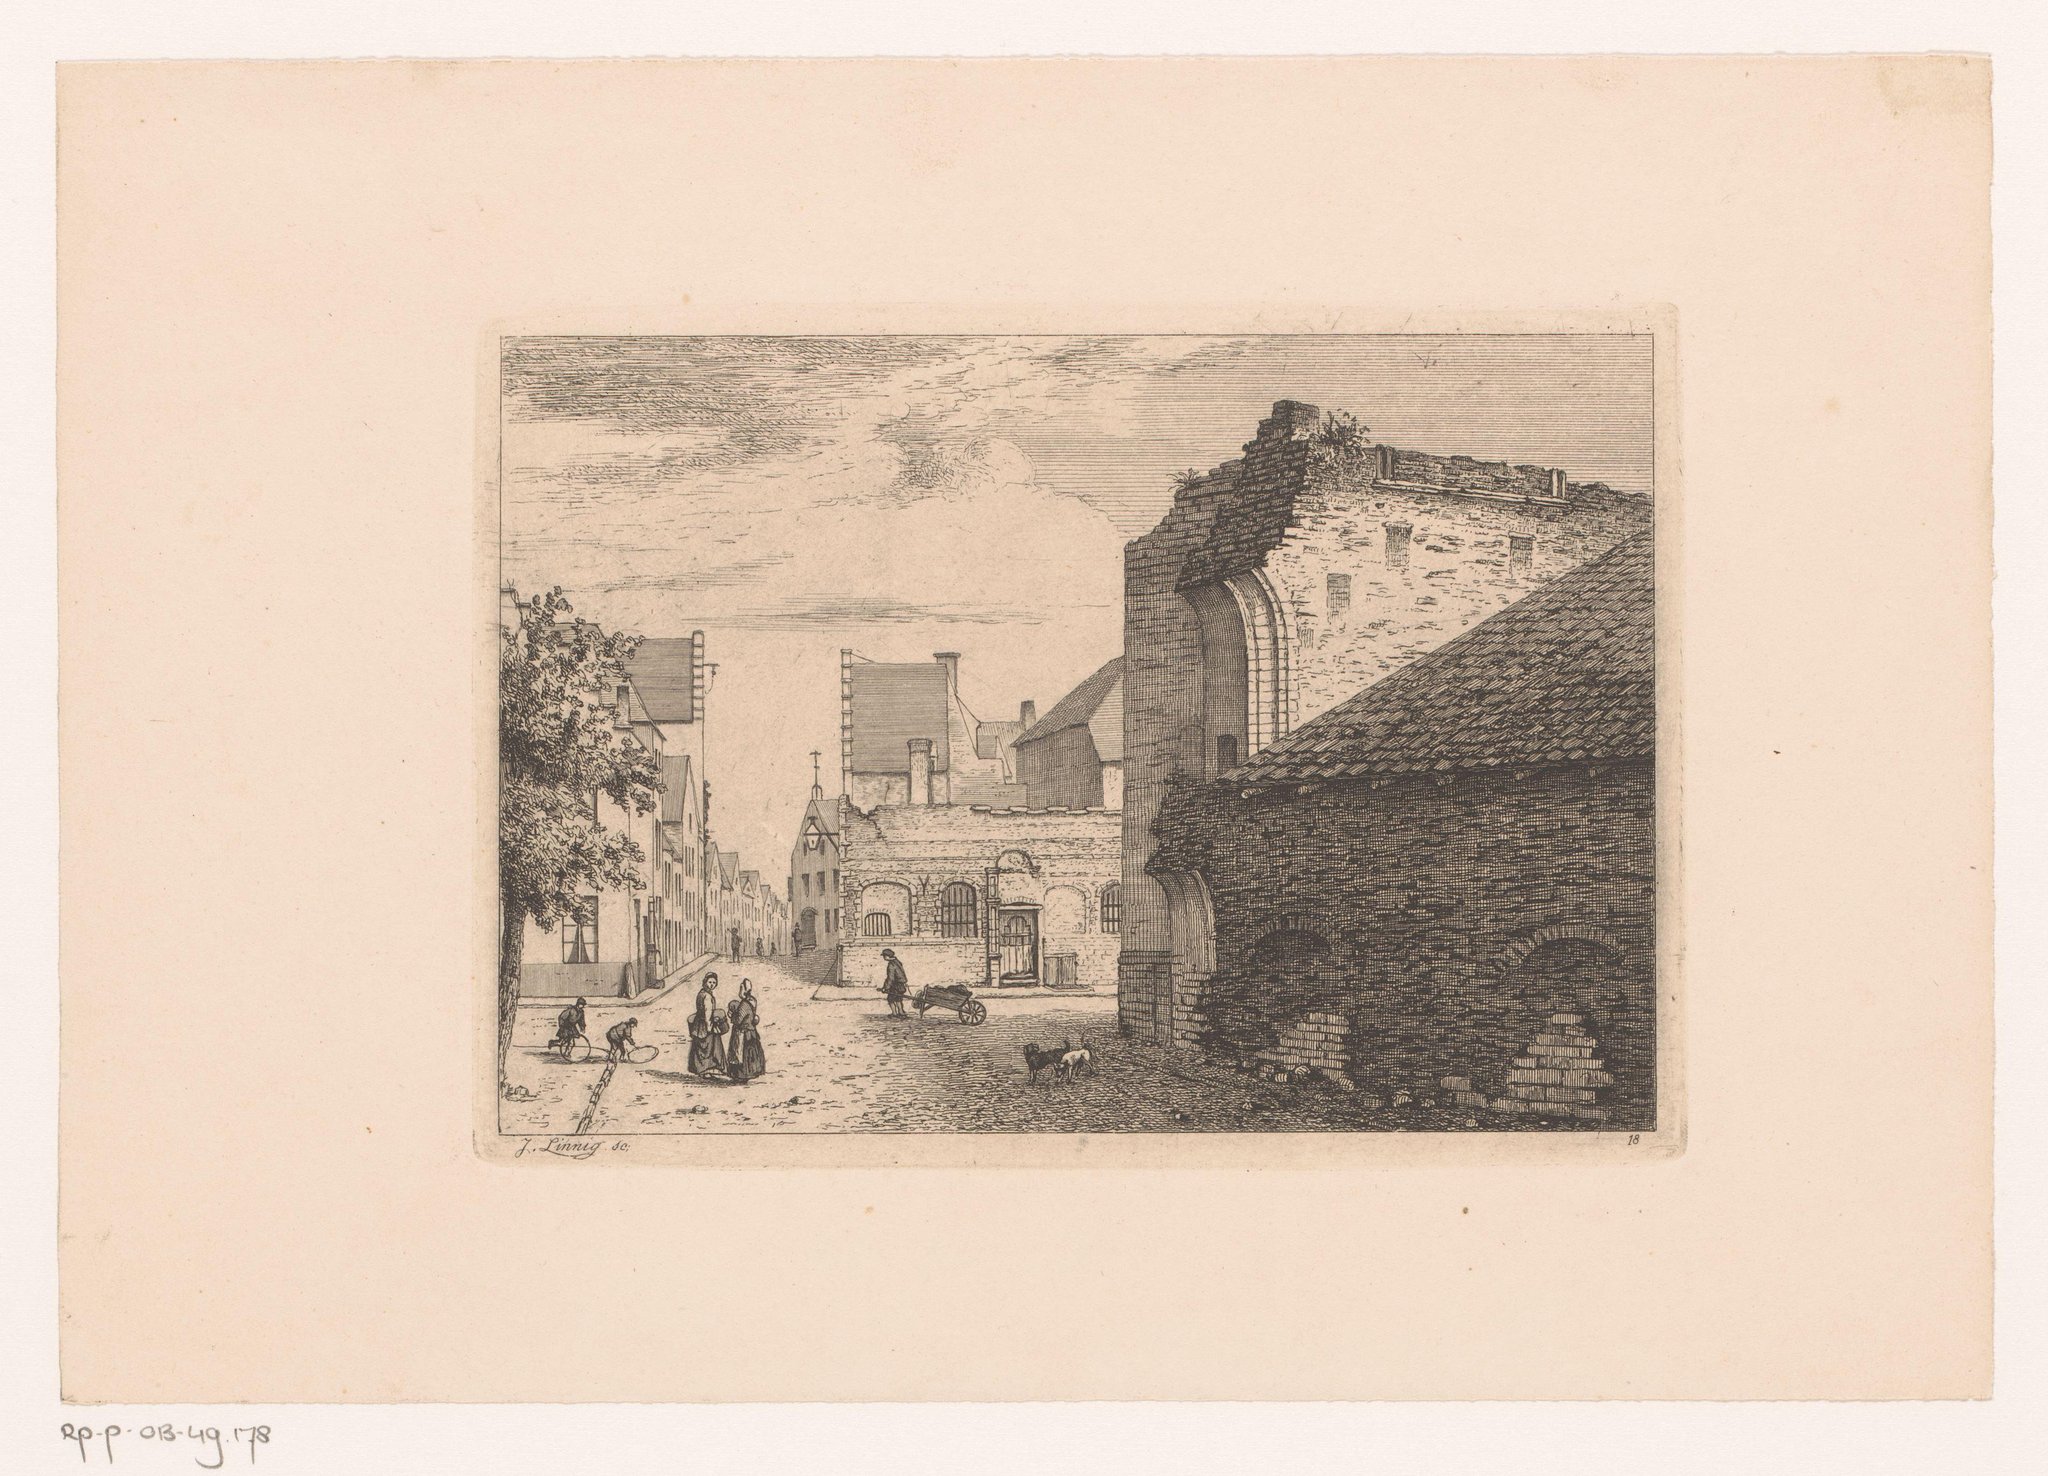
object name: book illustration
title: Stadsgezicht met de crypte van de Sint-Walburgiskerk in Antwerpen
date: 1868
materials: paper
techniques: etching, intaglio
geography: antwerp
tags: street, antwerp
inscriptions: collector's mark: Lugt 2228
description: Prent uit: Mertens, F.H. Album historique de la ville d'Anvers [...]. Antwerpen: J.E. Buschmann, 1868.